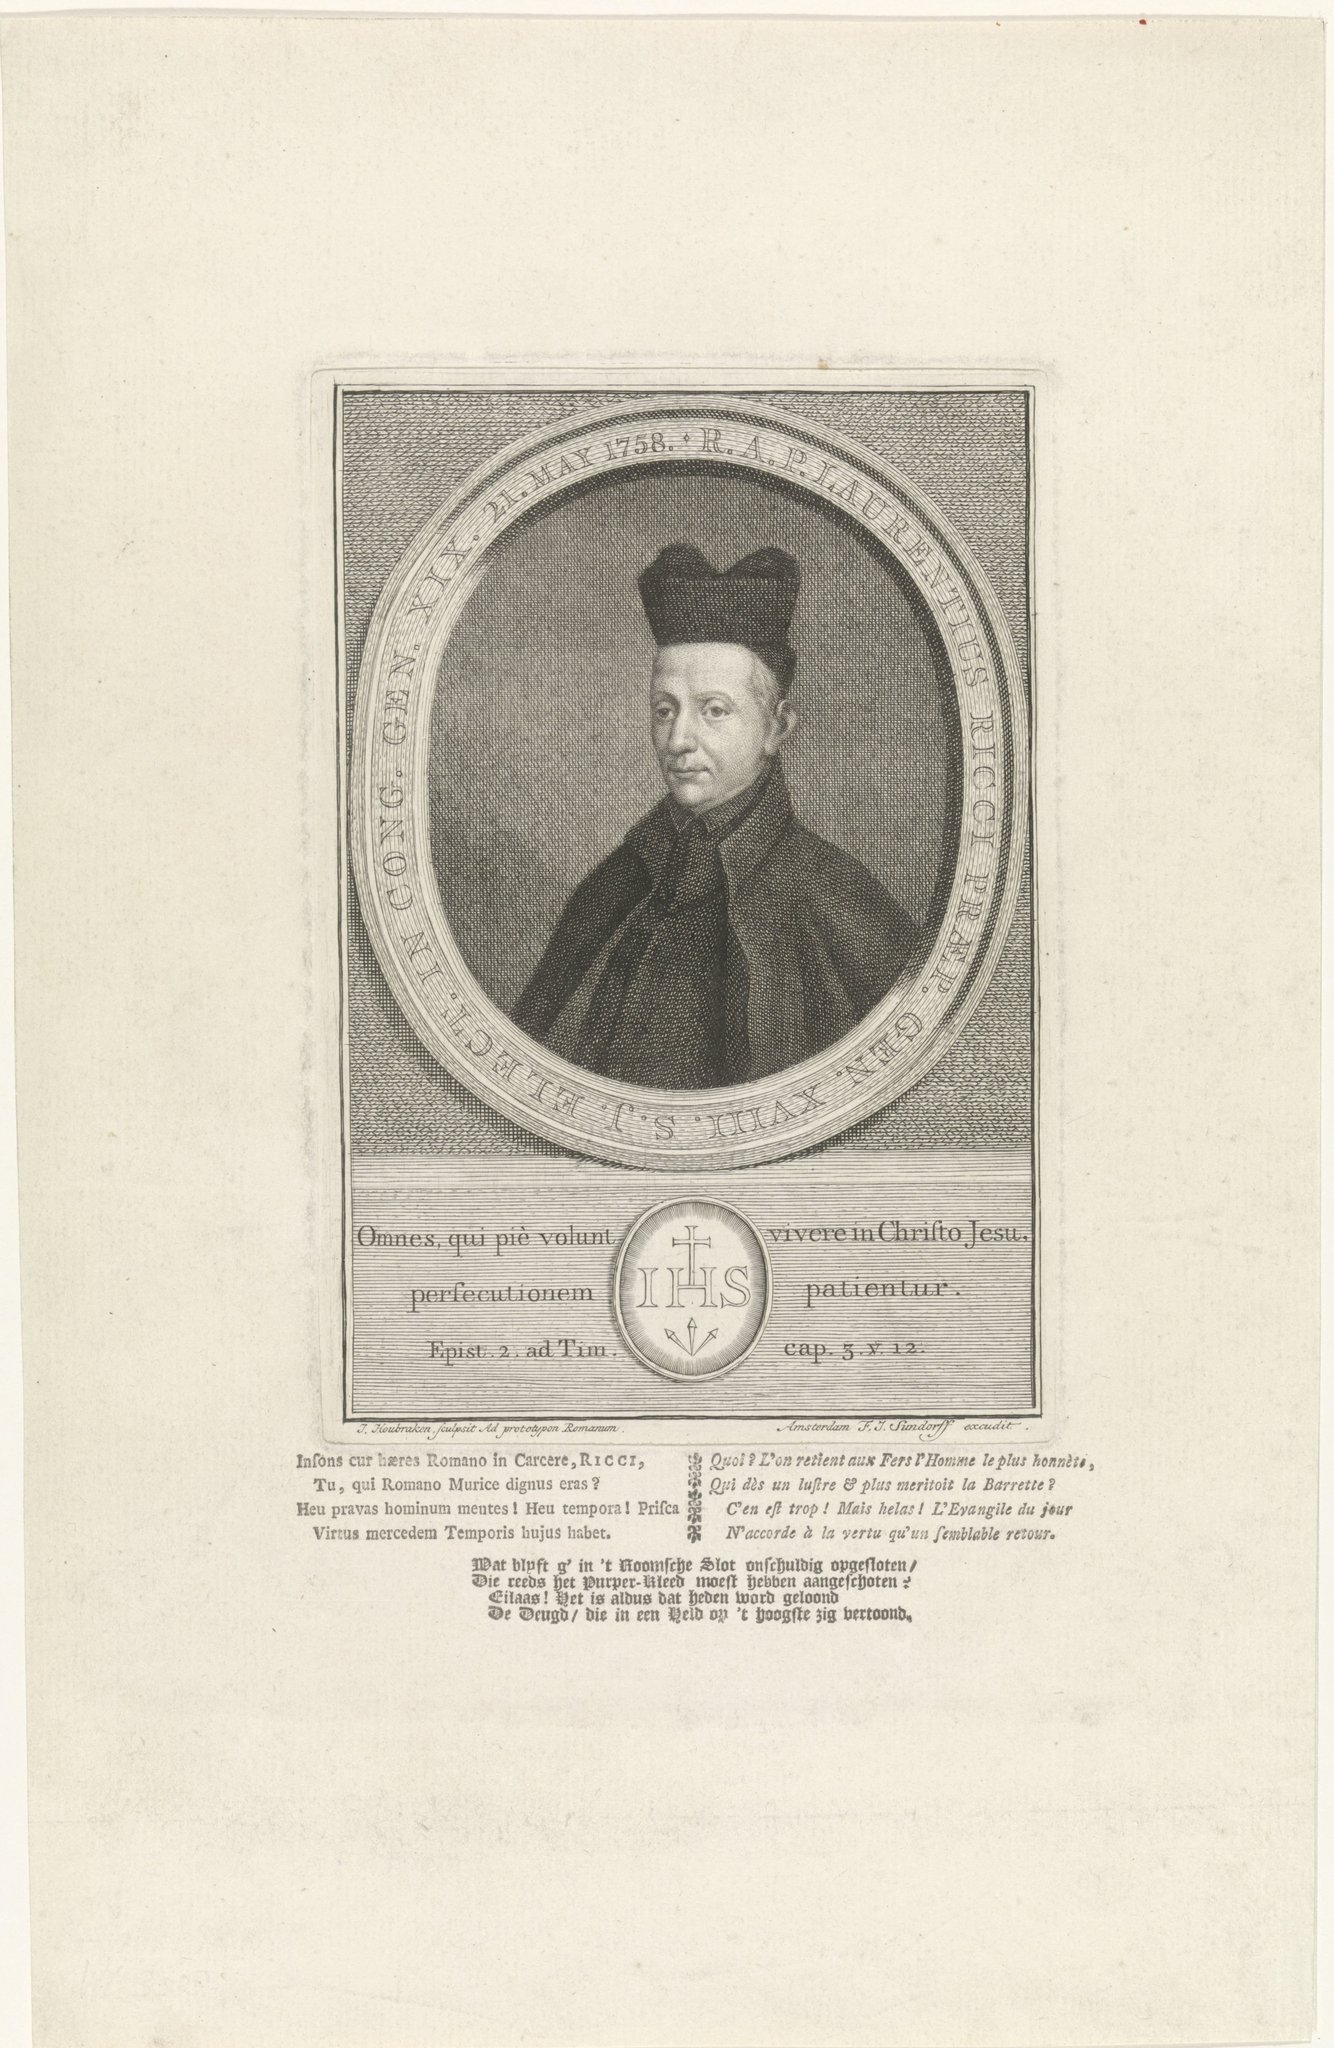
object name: print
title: Portret van Laurentius Ricci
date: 1708-1780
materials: paper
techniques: engraving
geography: amsterdam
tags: hierarchy of jurisdiction ~ roman catholic church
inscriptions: collector's mark: Lugt 2228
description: Buste naar links van Laurentius Ricci in een ovaal met randschrift in het Latijn. Het portret rust op een piëdestal waarop in een ovaal het monogram van Christus gevormd uit de letters I.H.S. en drie regels in het Latijn. Onder de voorstelling in boekdruk in de marge twee kolommen van elk vier regels; links in het Latijn en rechts in het Frans en daaronder vier regels in het Nederlands.